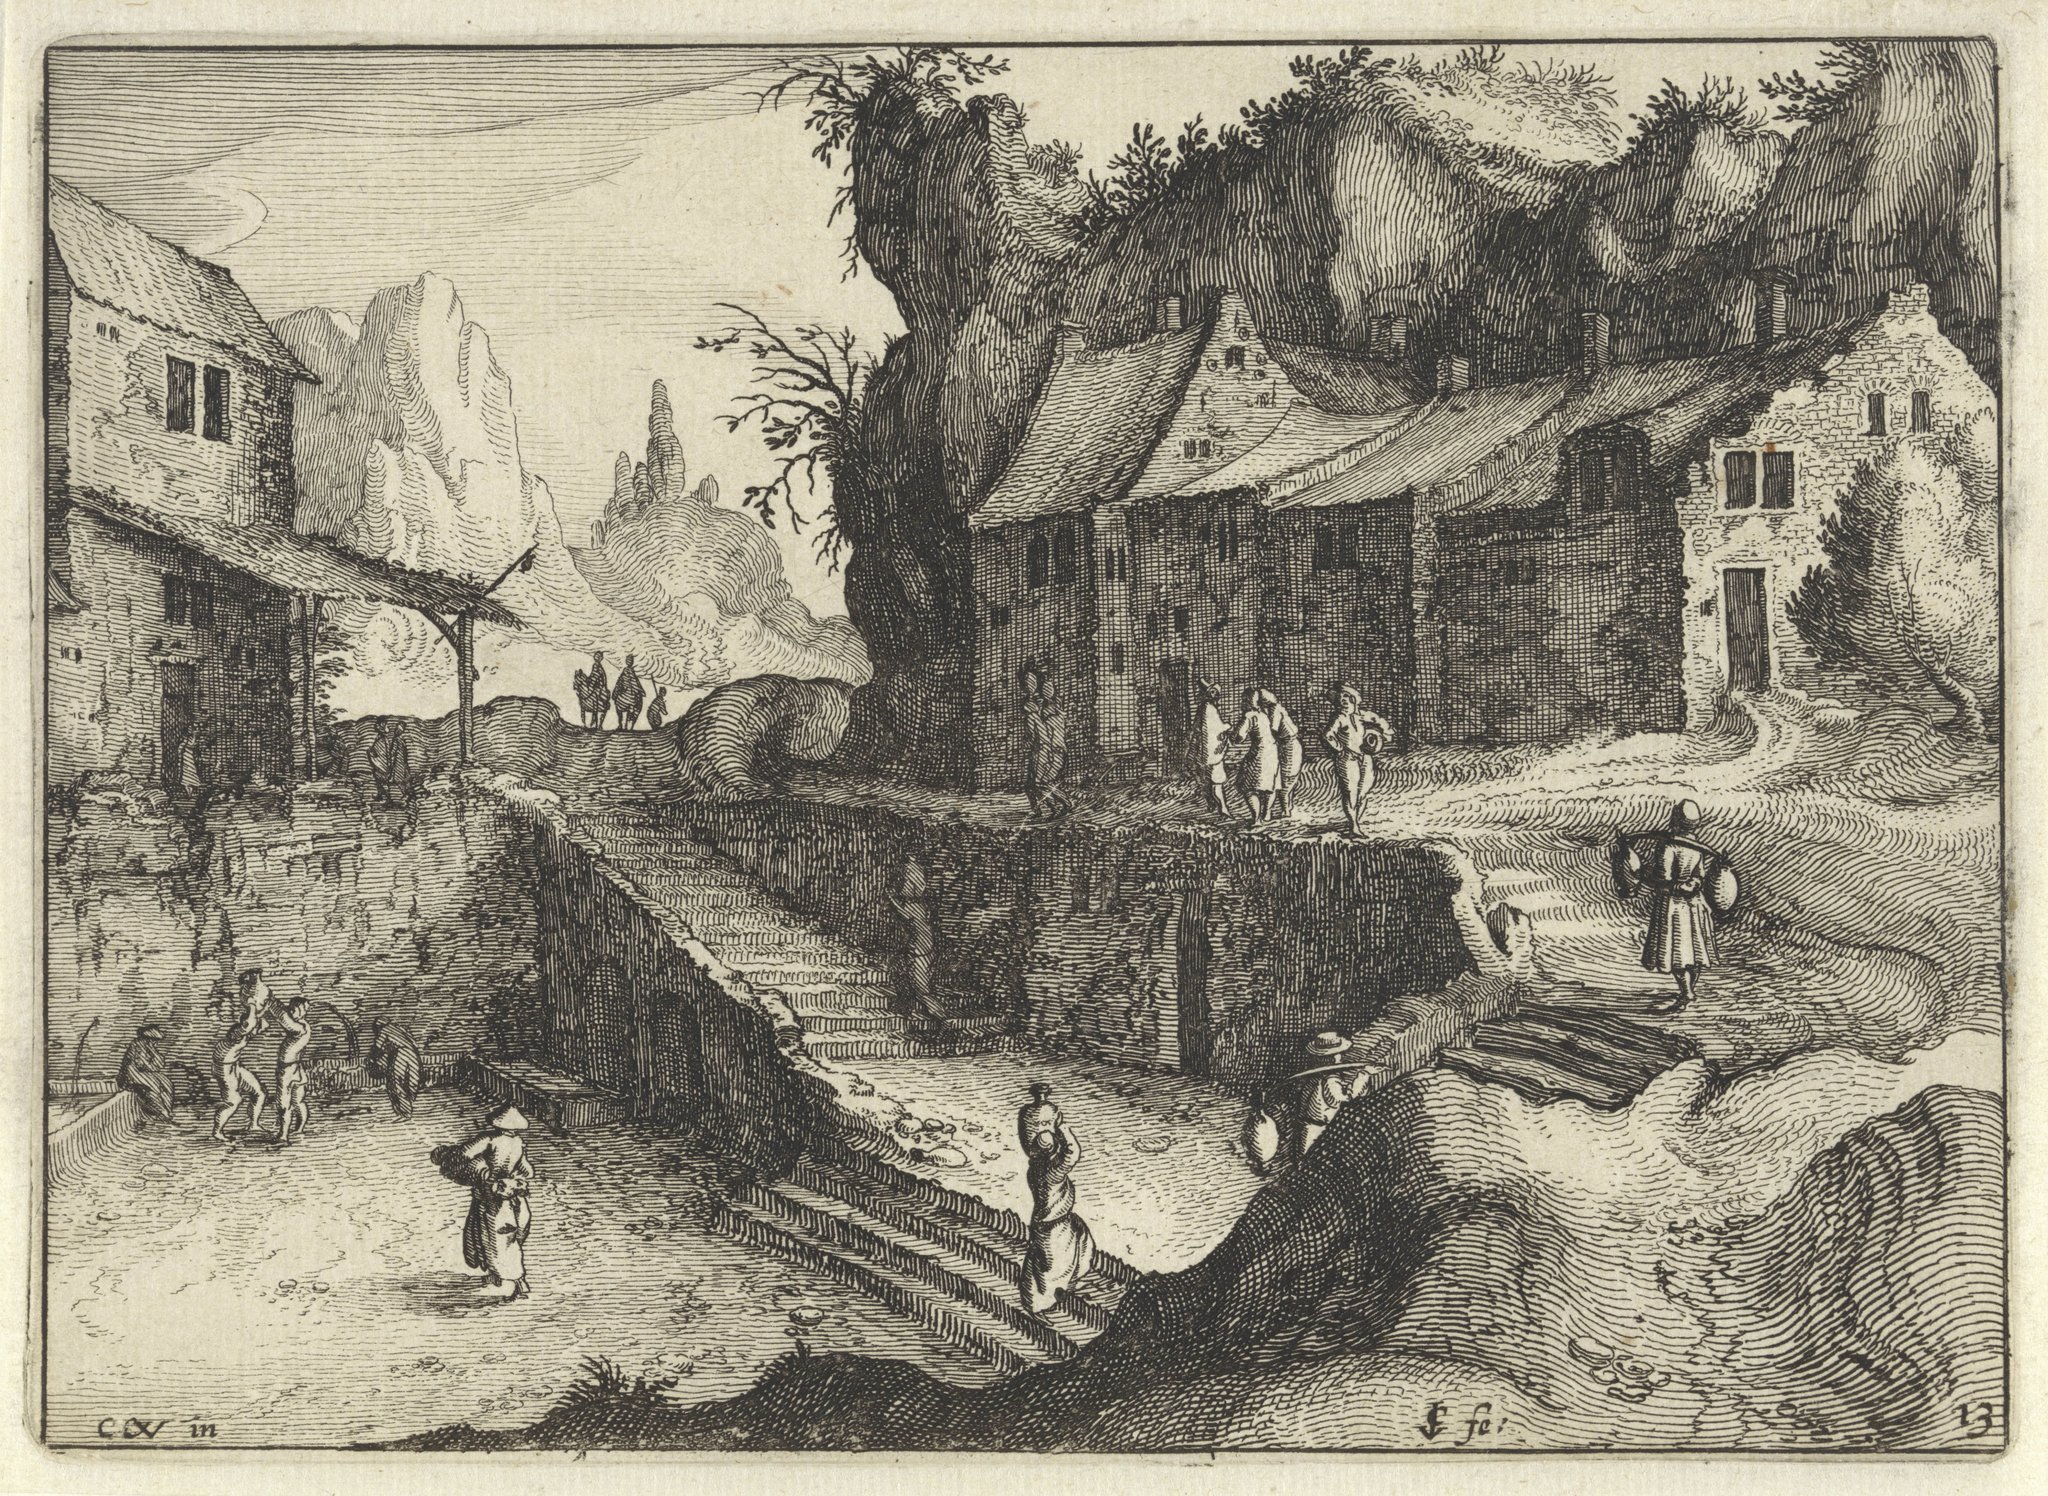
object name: print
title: Amaeniores Aliquot Regiunculae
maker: claes jansz. visscher (ii)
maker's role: draughtsman, print maker, publisher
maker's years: 1586-1652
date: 1613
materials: paper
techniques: etching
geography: amsterdam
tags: rural housing, e.g. country-house, villa, cottage, staircase, mound, verge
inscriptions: collector's mark: Lugt 2228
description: Landschap met trap naar huizen op een heuvel. Verschillende figuren dragen kannen water de trap op.